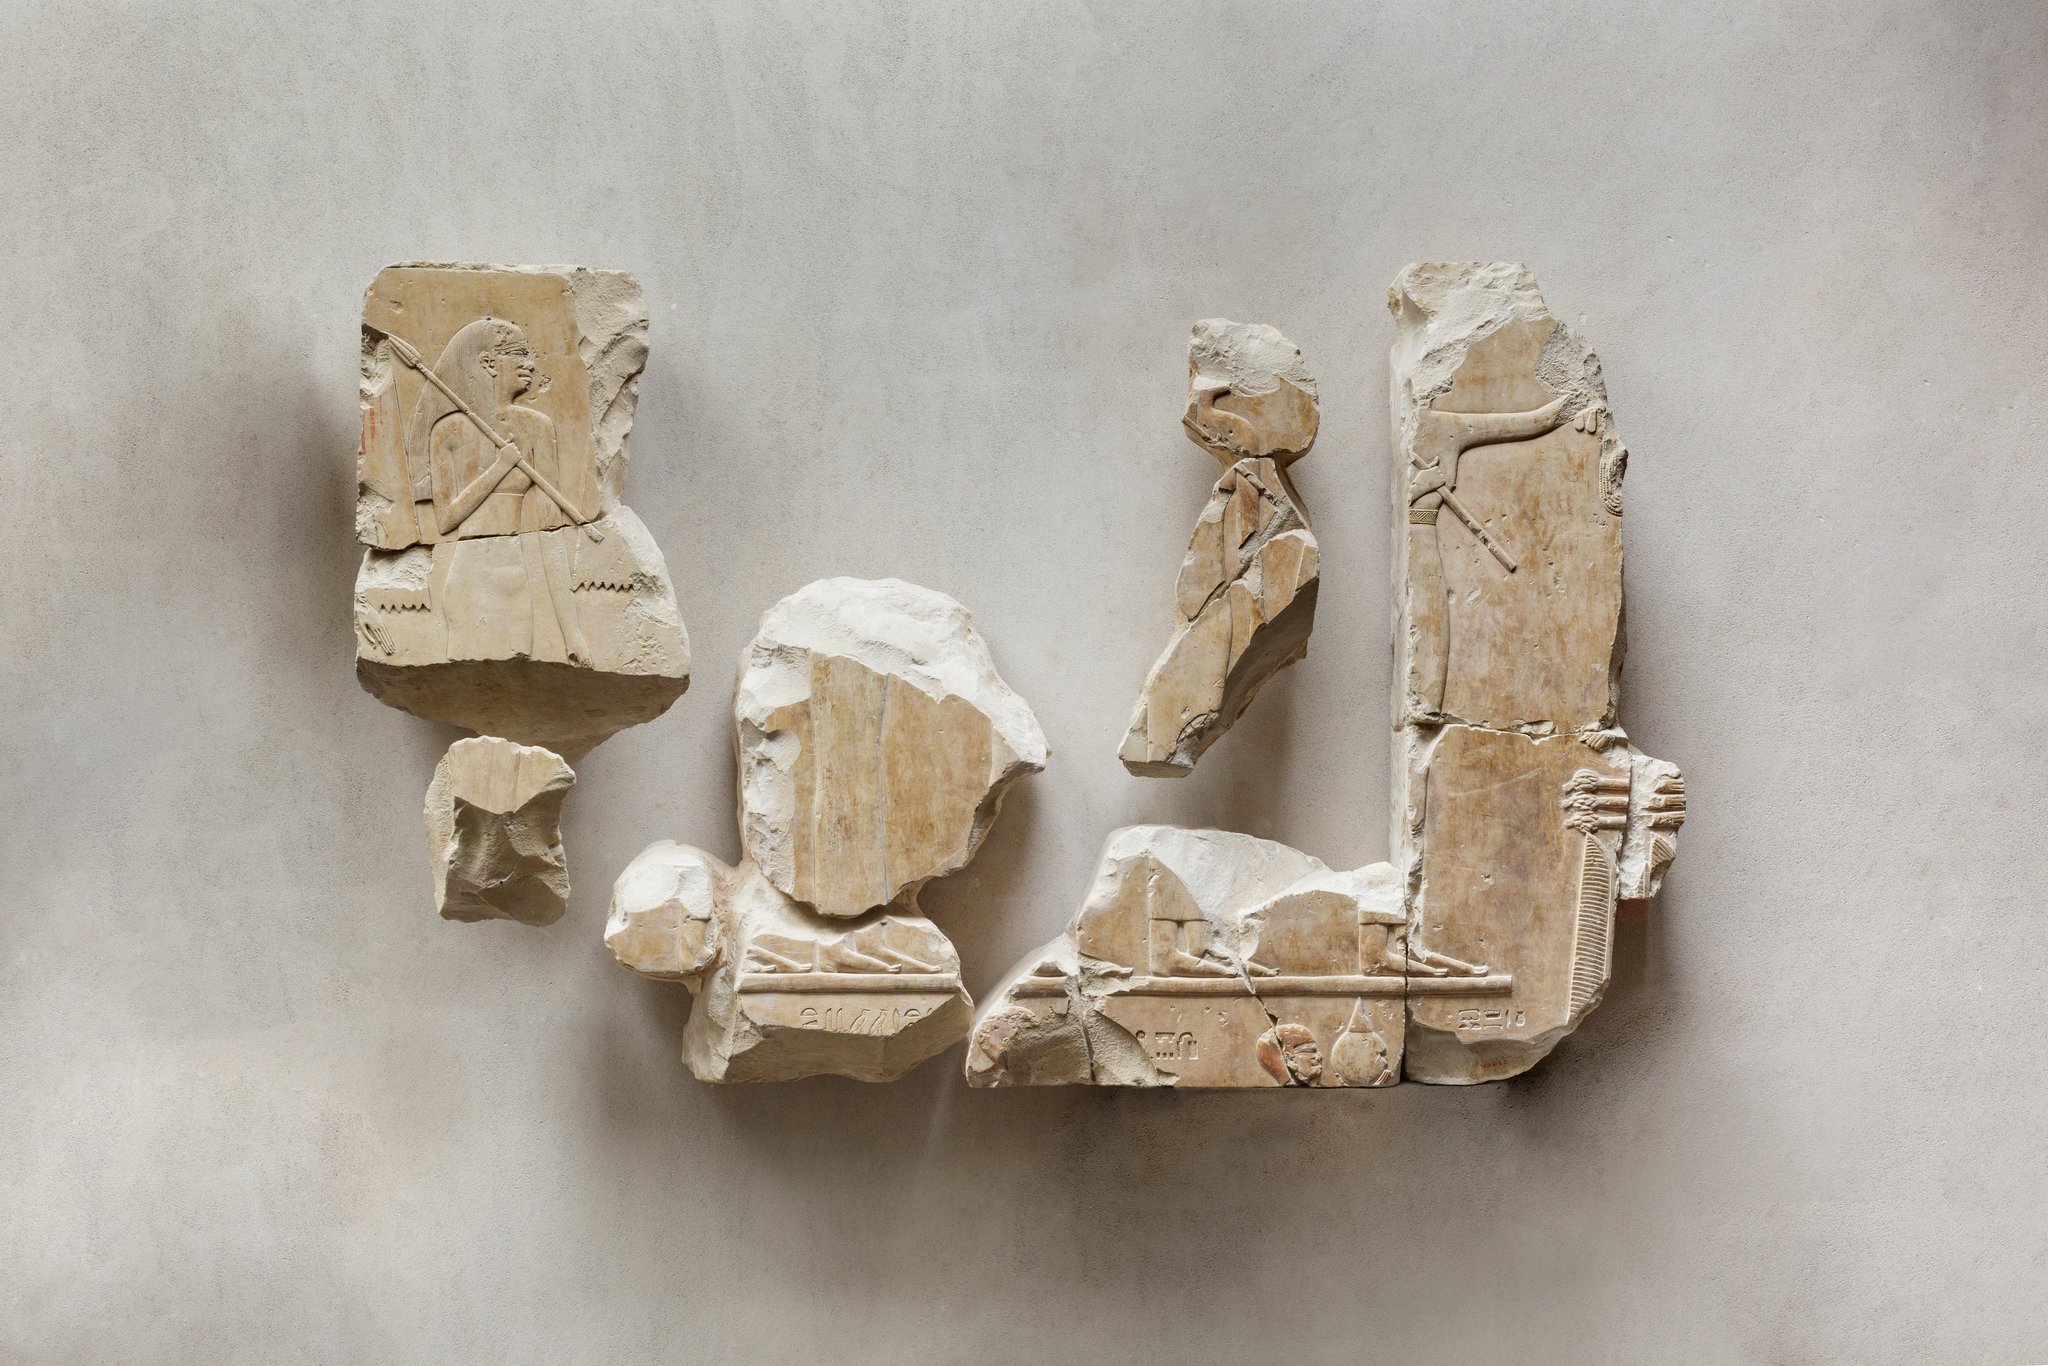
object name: relief, attendant before offering table, neferu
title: Relief fragments from the tomb of Queen Neferu: male and female attendants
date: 2051-2030 BCE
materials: limestone, paint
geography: egypt